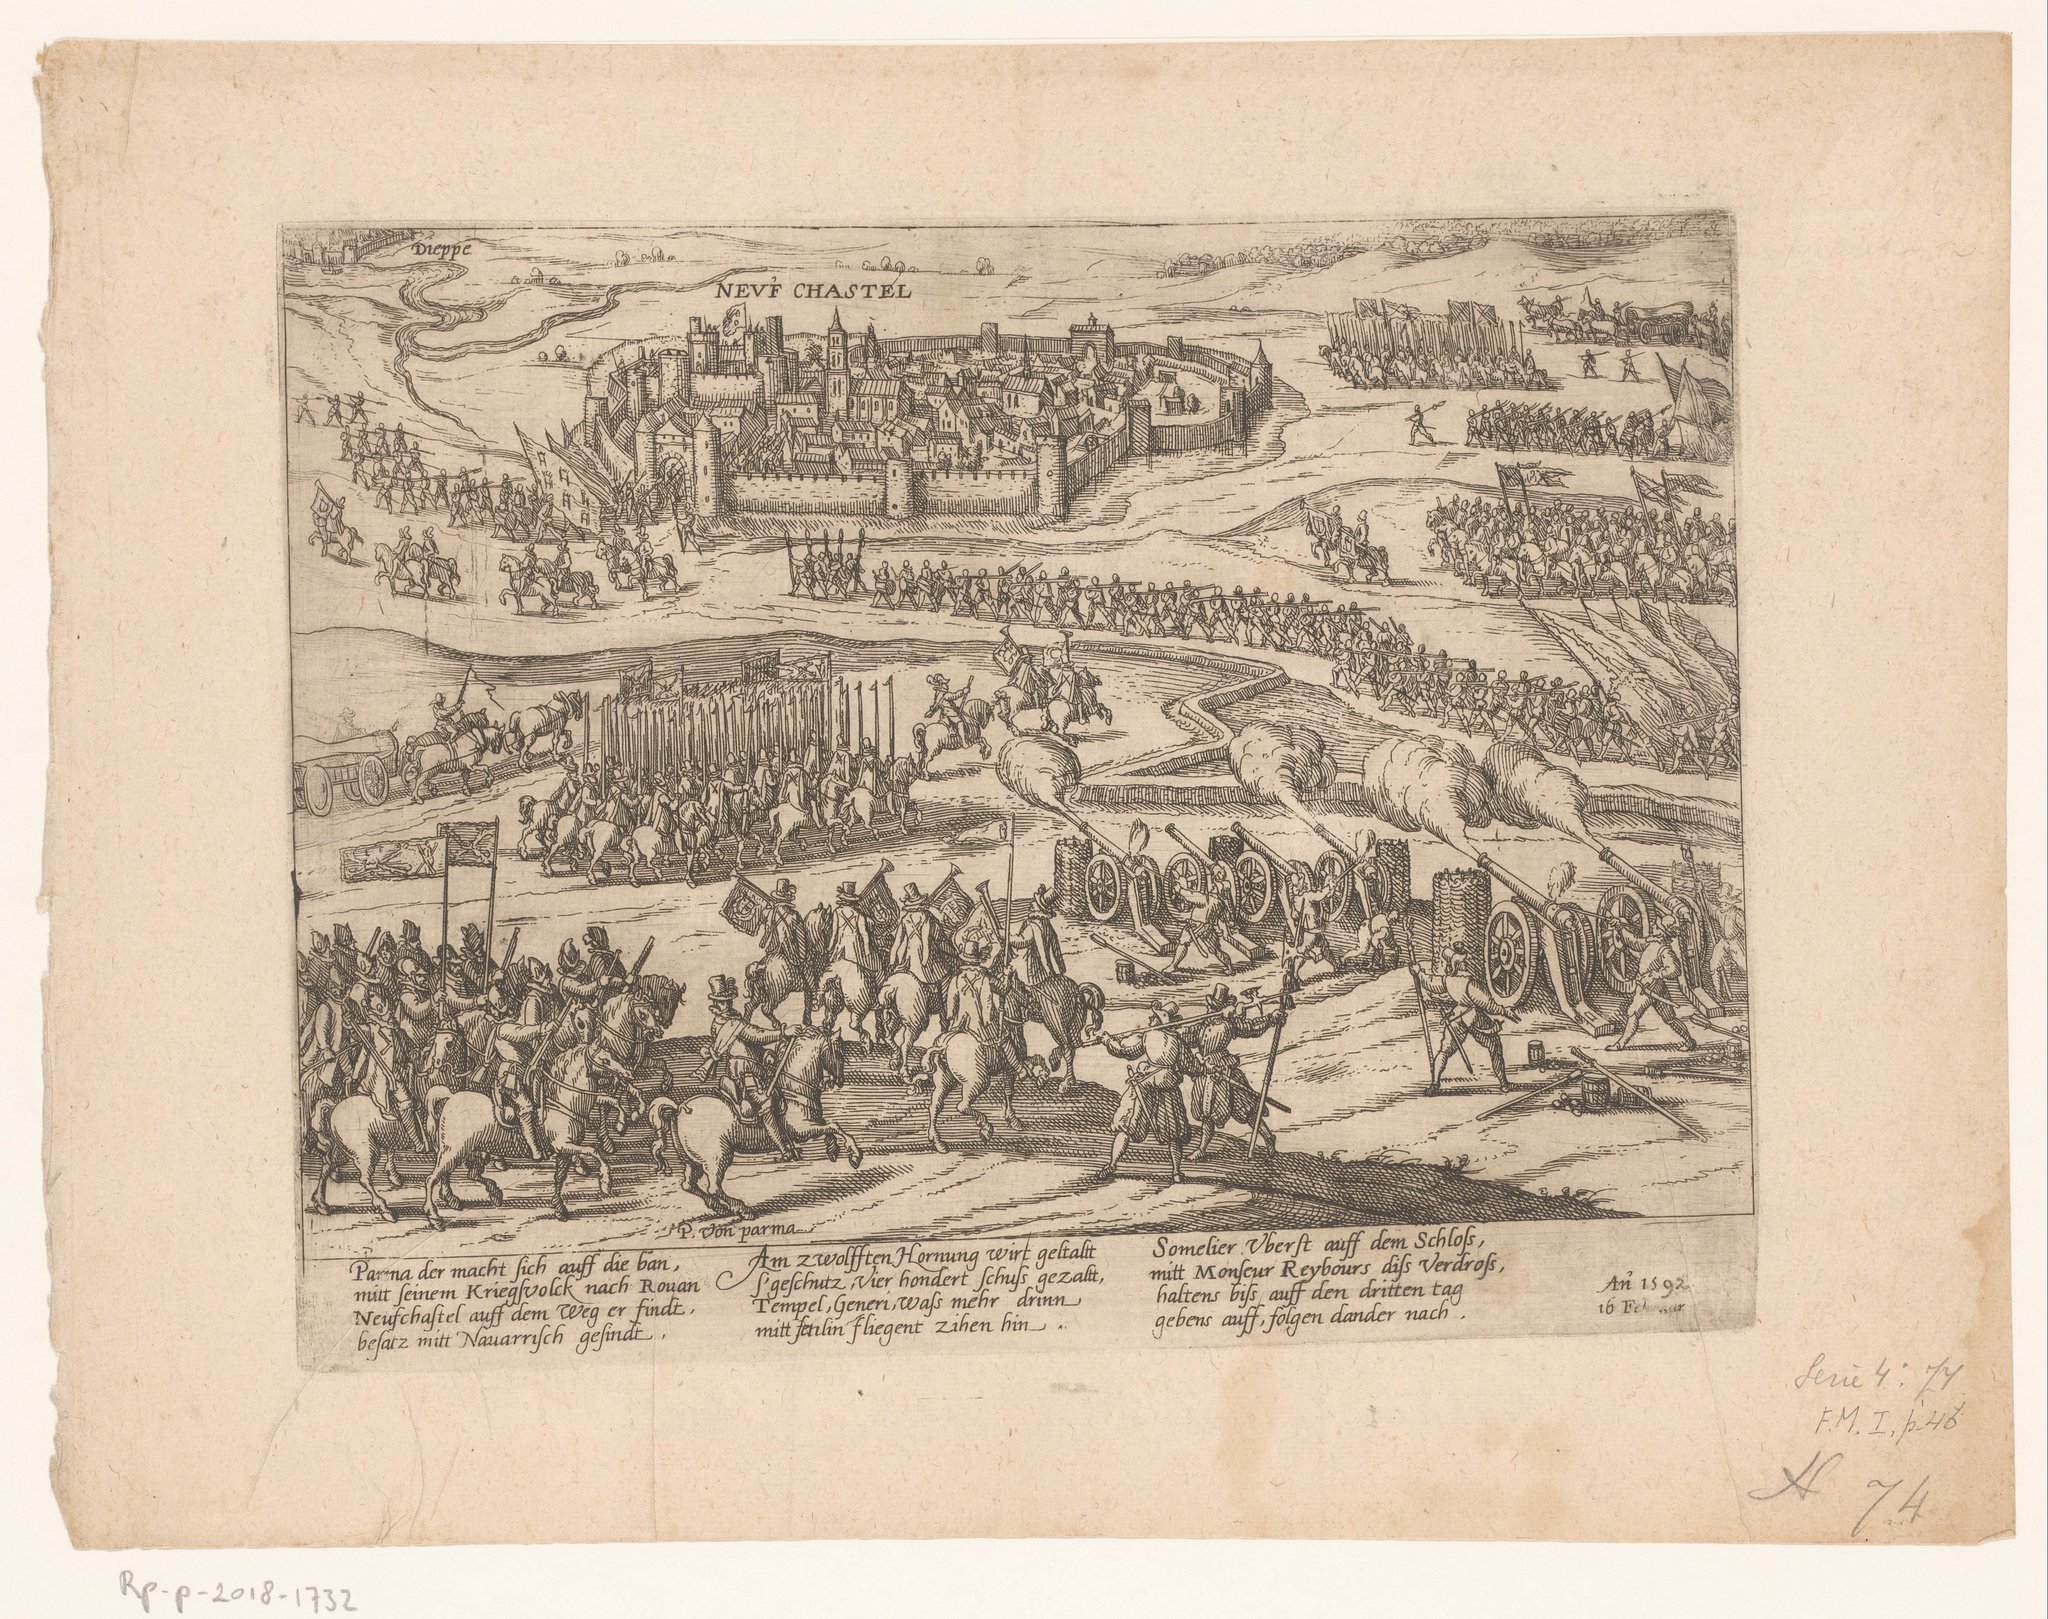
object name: print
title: Neuf Chastel / Parma der macht sich auss die ban, mett seinem (...)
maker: Anonymous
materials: paper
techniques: etching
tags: prospect of village, silhouette of village, siege